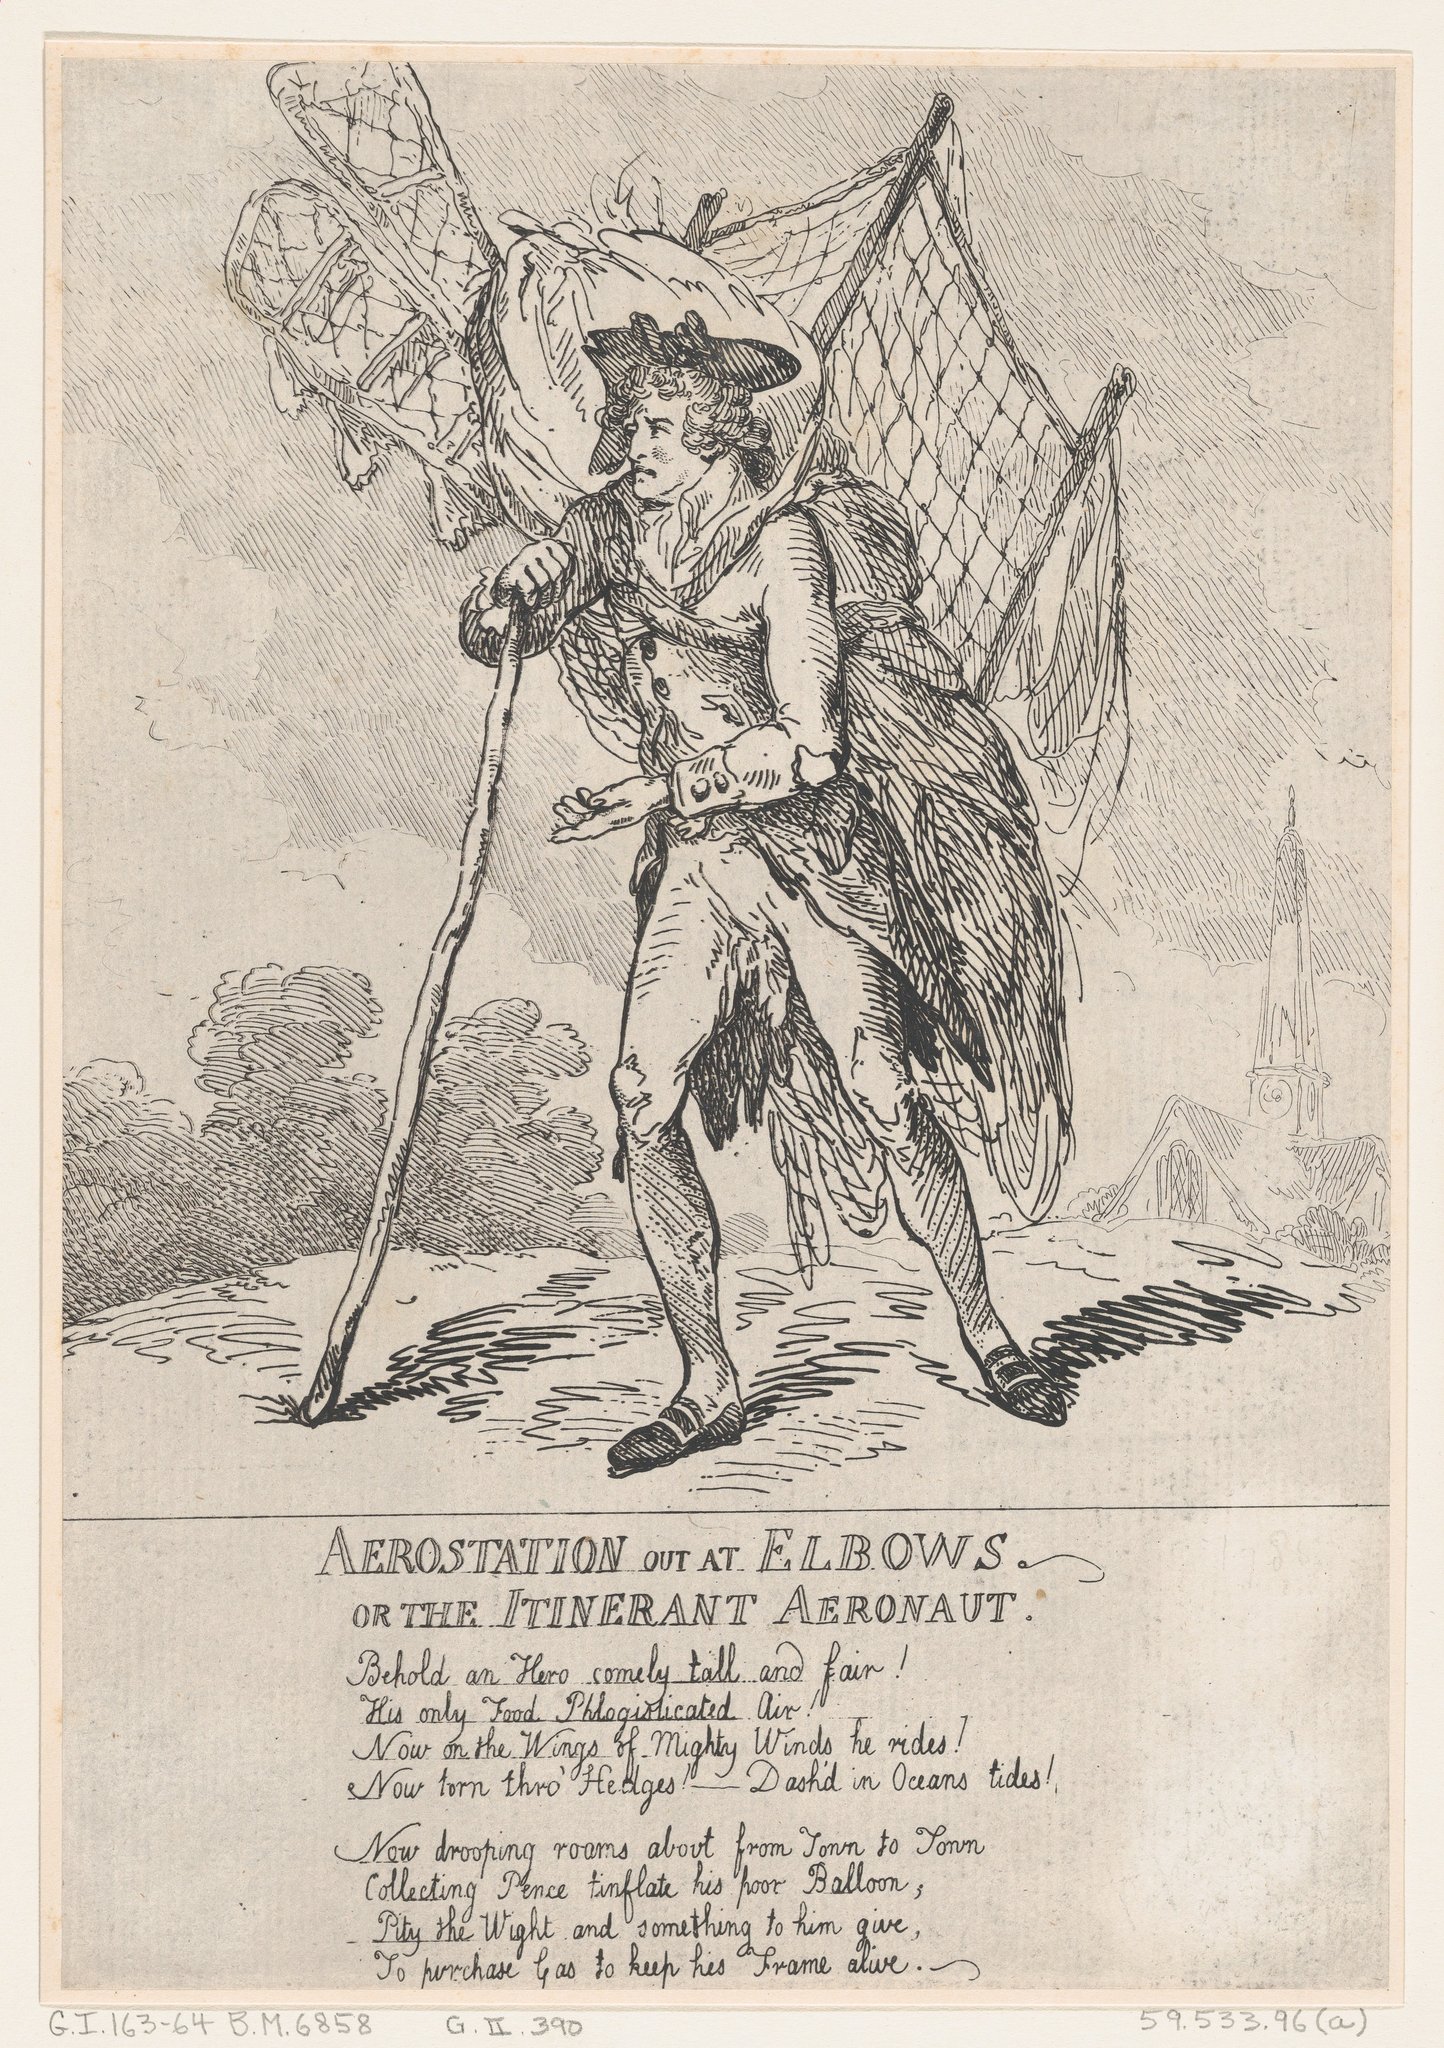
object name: print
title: Aerostation out at Elbows, or The Itinerant Aeronaut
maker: thomas rowlandson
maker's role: artist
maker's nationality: british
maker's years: 1757-1827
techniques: etching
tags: men